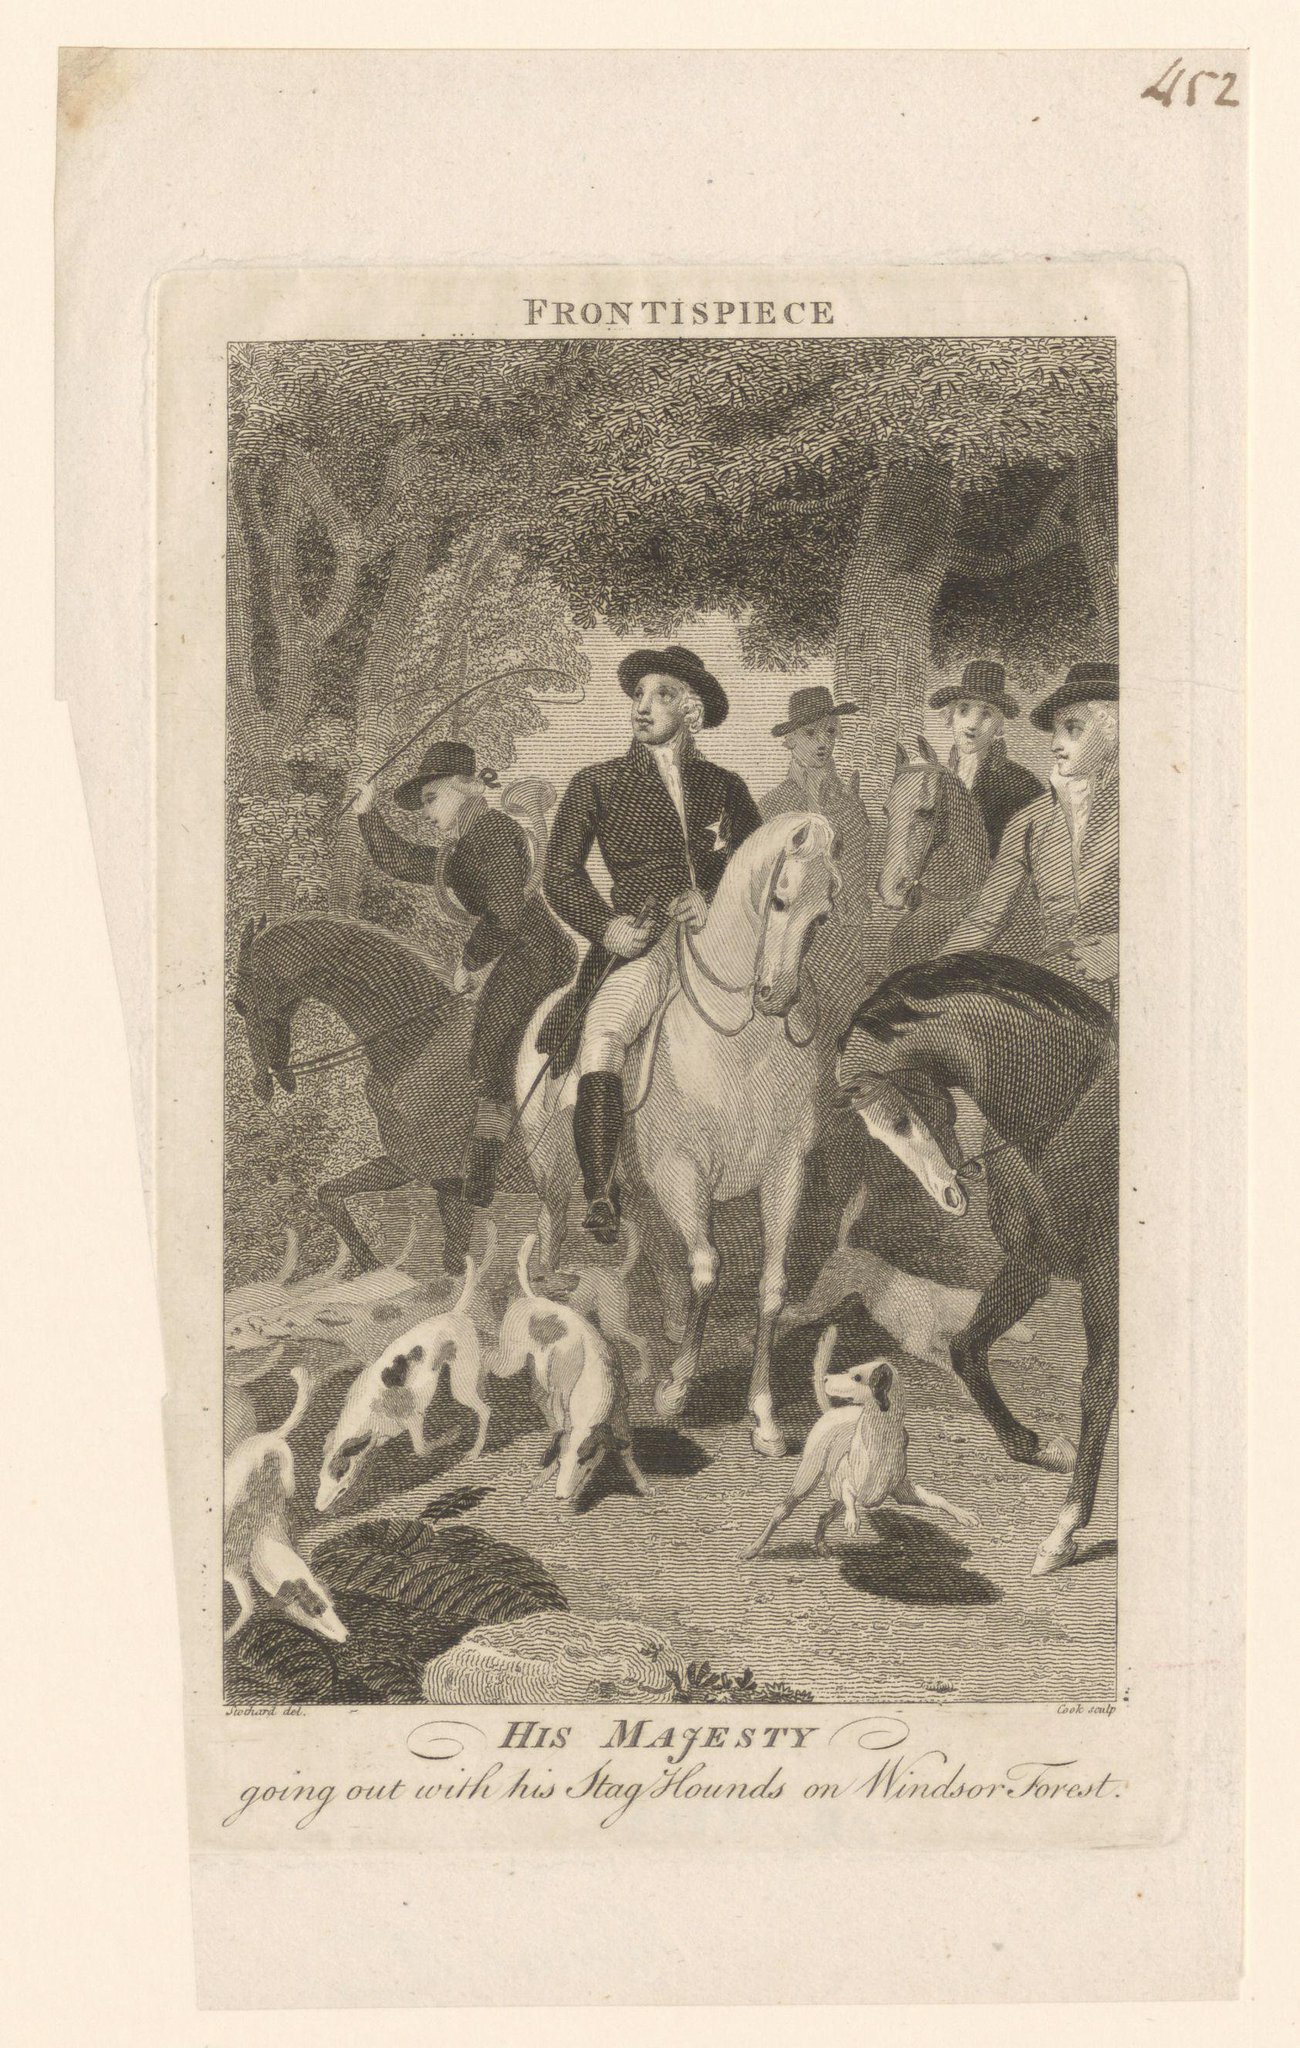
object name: print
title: His Majesty going out with his StagHounds on Windsor Forest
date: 1793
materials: paper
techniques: etching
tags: george iii (koning van het verenigd koninkrijk), hunting, chase, historical persons, king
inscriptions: collector's mark: Lugt 2228, number: ‘452’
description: Prent gebruikt in: Sporting Magazine 1 (1793), p. 257.